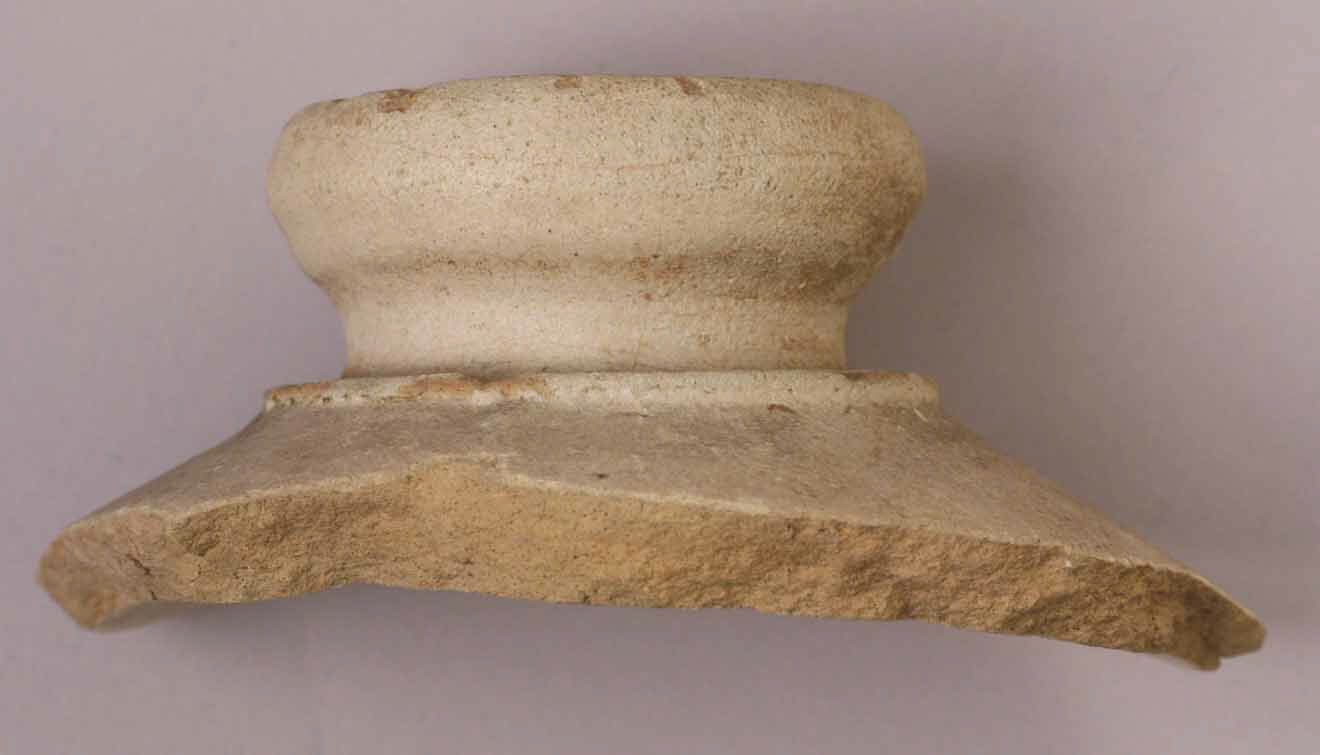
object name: fragment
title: Ceramic Fragment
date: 101-700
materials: earthenware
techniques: glazing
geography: iraq